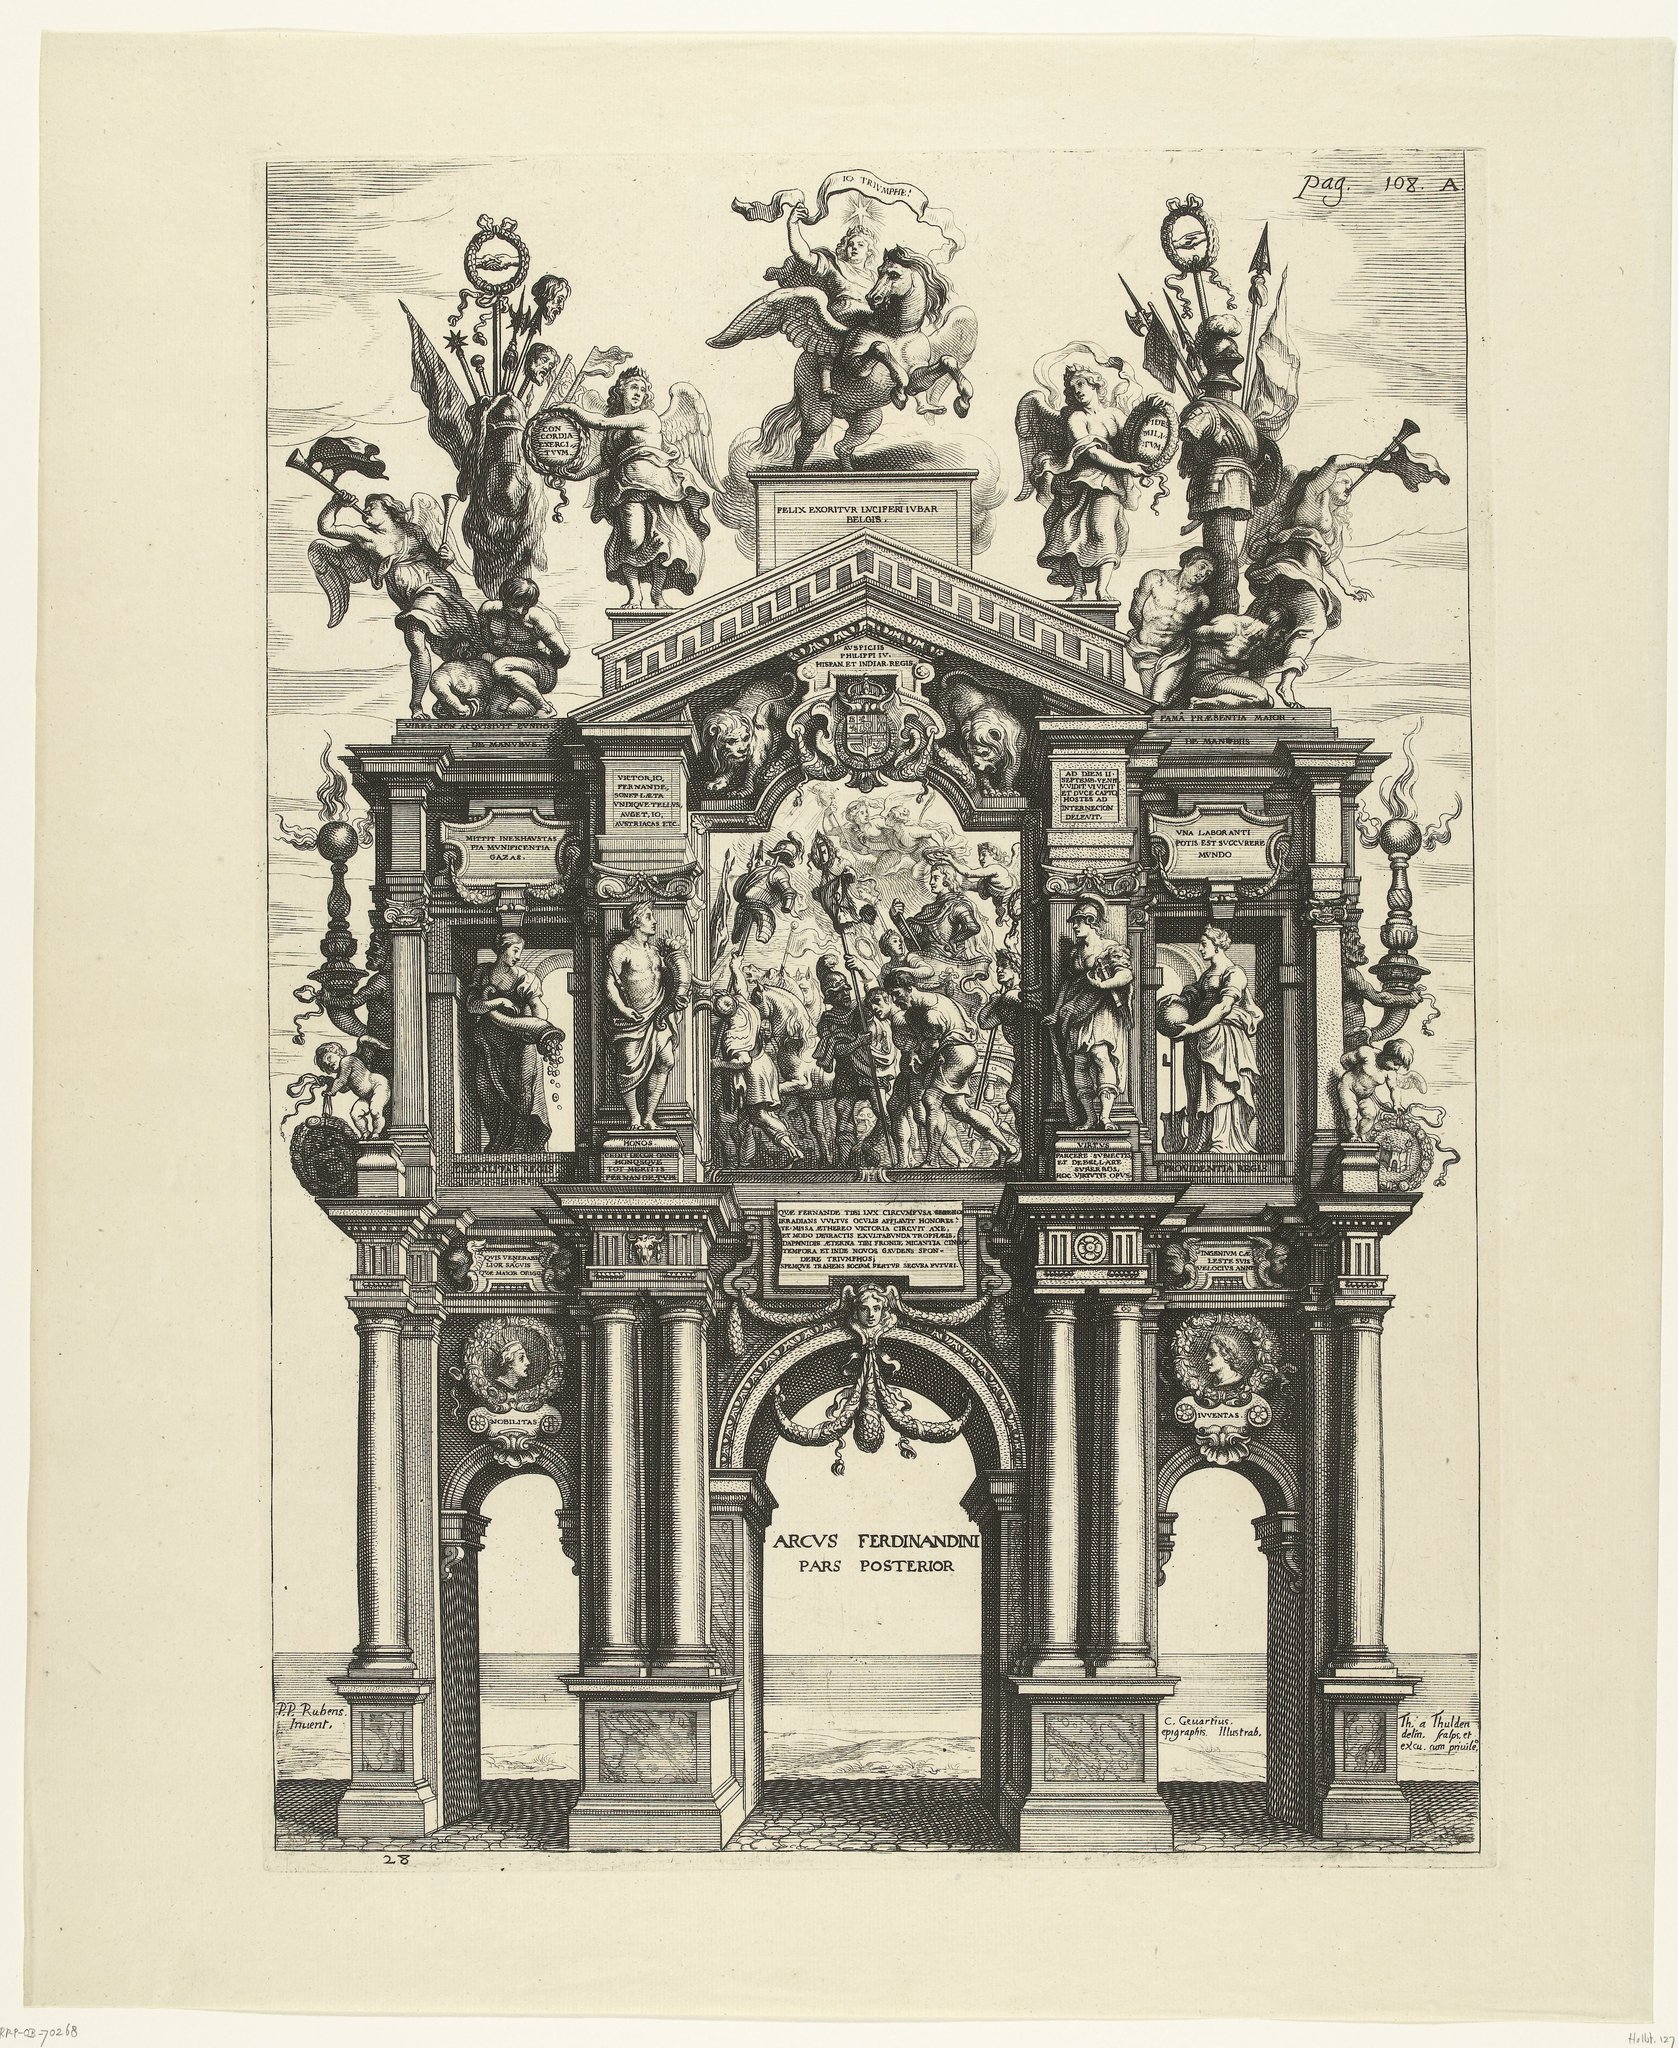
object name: print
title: Triomfboog van Ferdinand (achterzijde); intocht van Ferdinand te Antwerpen in 1635 (nr. 28)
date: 1639-1641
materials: paper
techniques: engraving, etching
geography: southern netherlands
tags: brussels, landvoogd der zuidelijke nederlanden ferdinand van oostenrijk, triumphal arch, symbolic triumphs of individual persons, conqueror triumphing, triumphal entry of victor, antwerp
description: Oorspronkelijk gebruikt als illustratie in: C. Gevartius, Pompa introitus ... Ferdinandi Austriaci Hispaniarum Infantis ... a S.P.Q. Antverp, decreta et adornata, cum ... ad Norlingam parta victoria Antverpiam ... adventu suo bearet ... 1635 : arcus, pegmata iconesque a Pet. Paulo Rubenio ... inventas & delineatas inscriptionibus & elogiis ornabat, libroque commentario illustrabat, Theodoor van Thulden en Joannes Meursius, Antwerpen 1641, pl. 28.